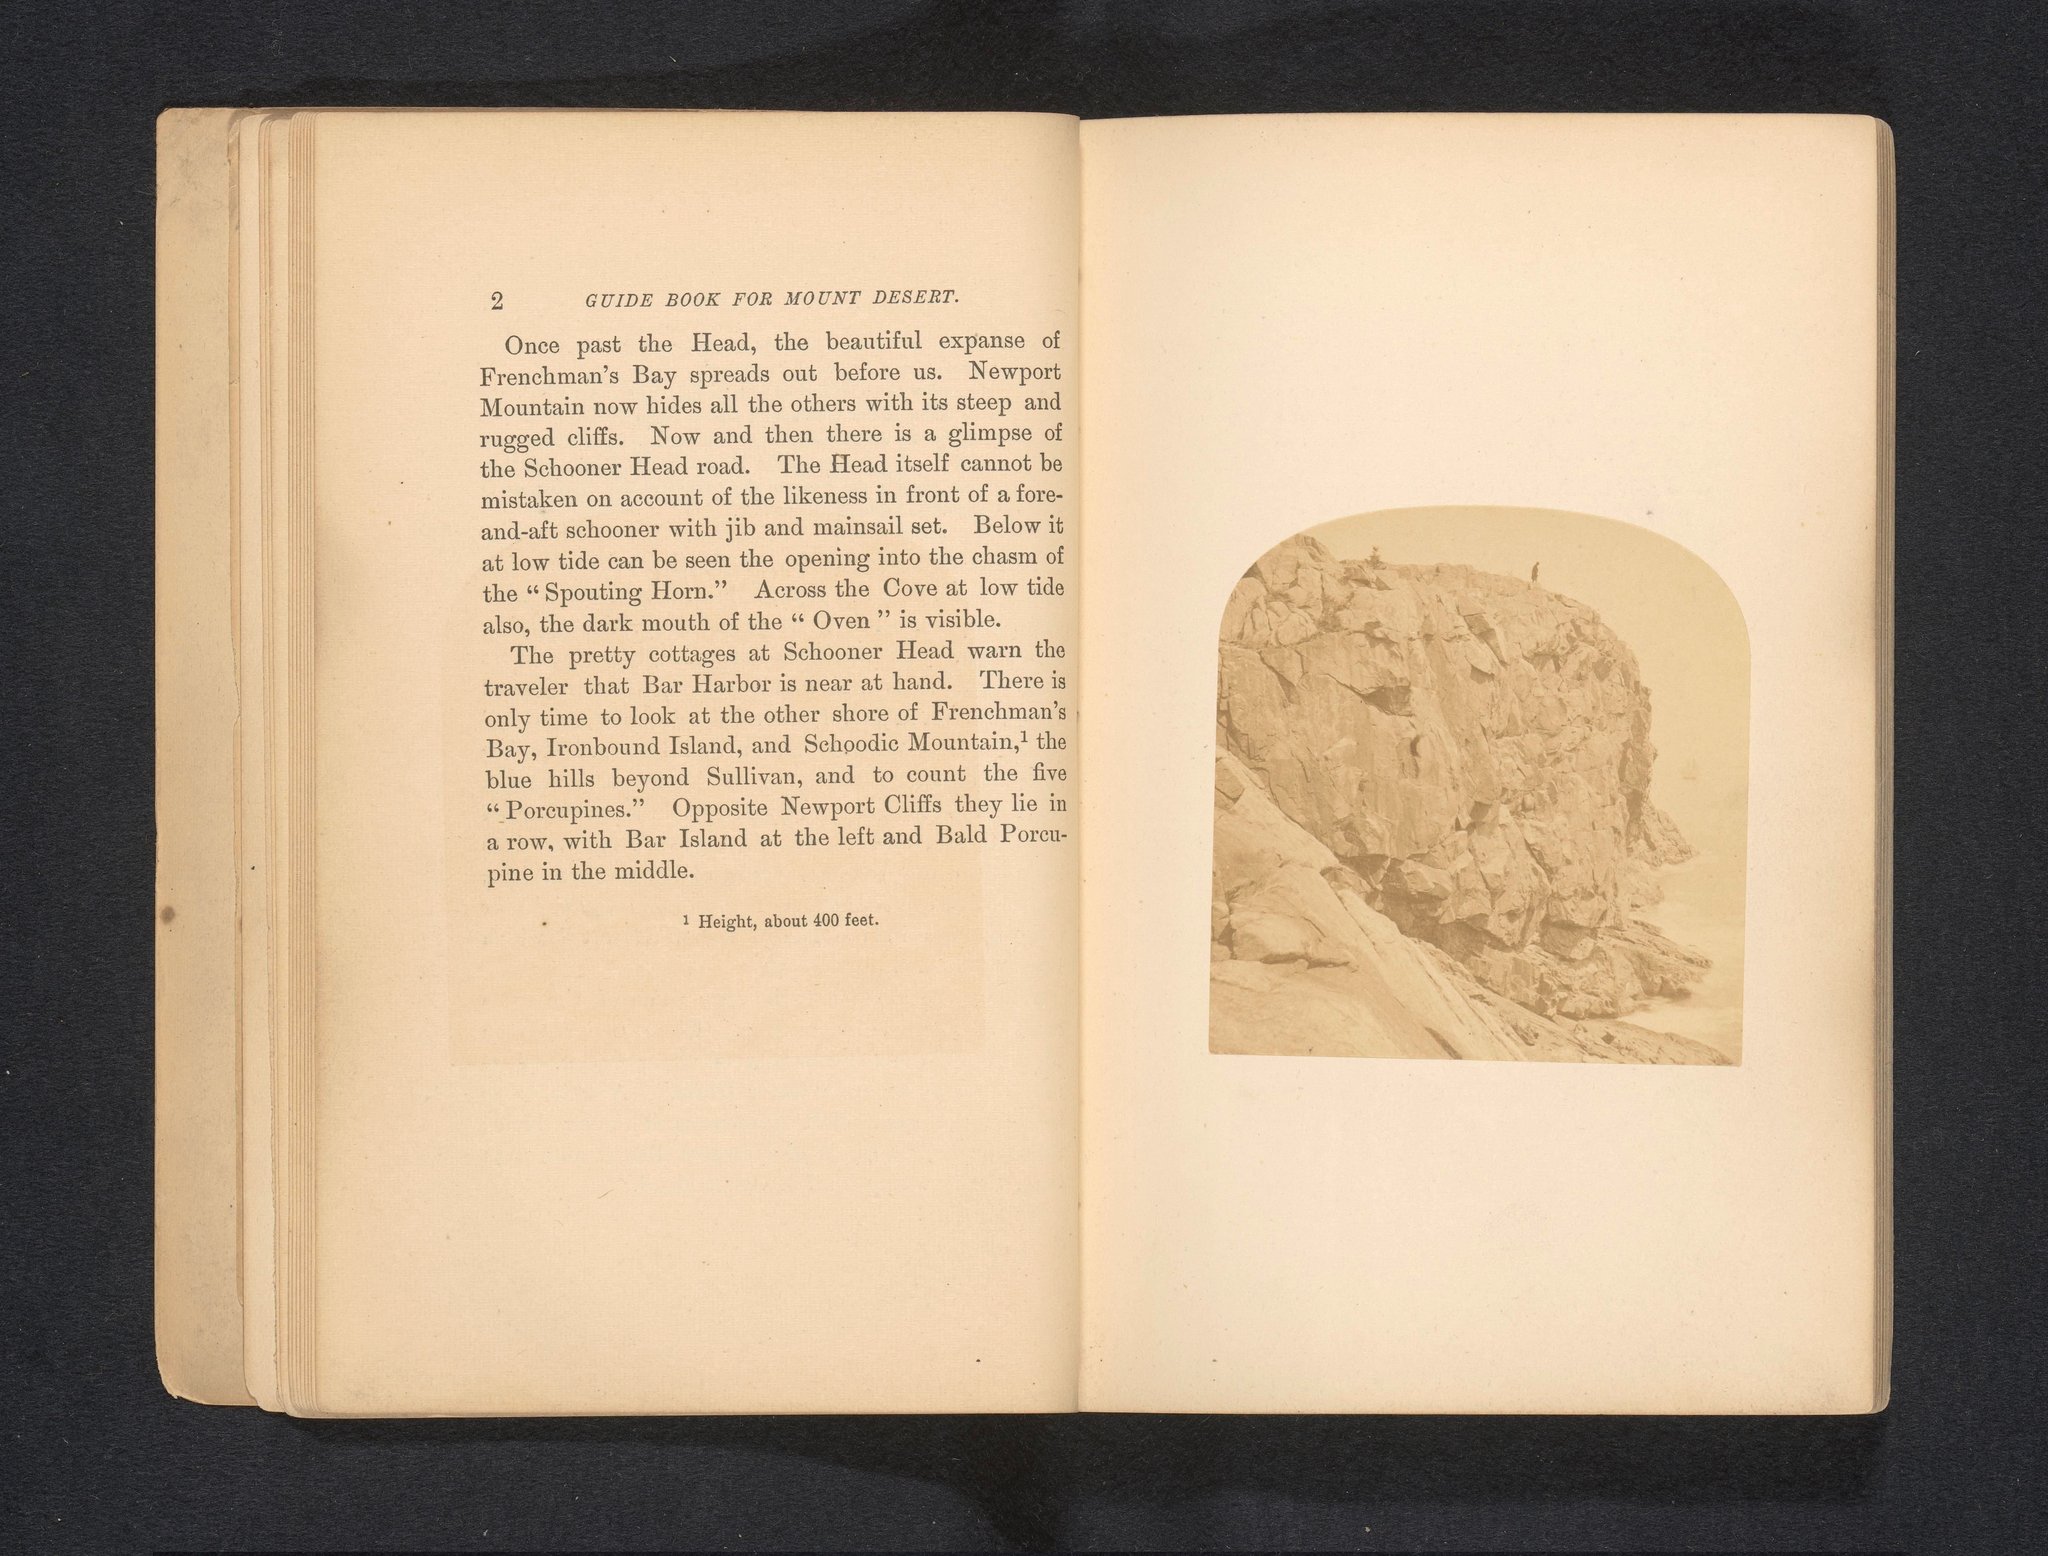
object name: photograph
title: Gezicht op de Great Head rotsen van Mount Desert Island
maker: Anonymous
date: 1877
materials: photographic support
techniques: albumen print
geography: mount desert island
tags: rock-formations, coastal cliff or crag